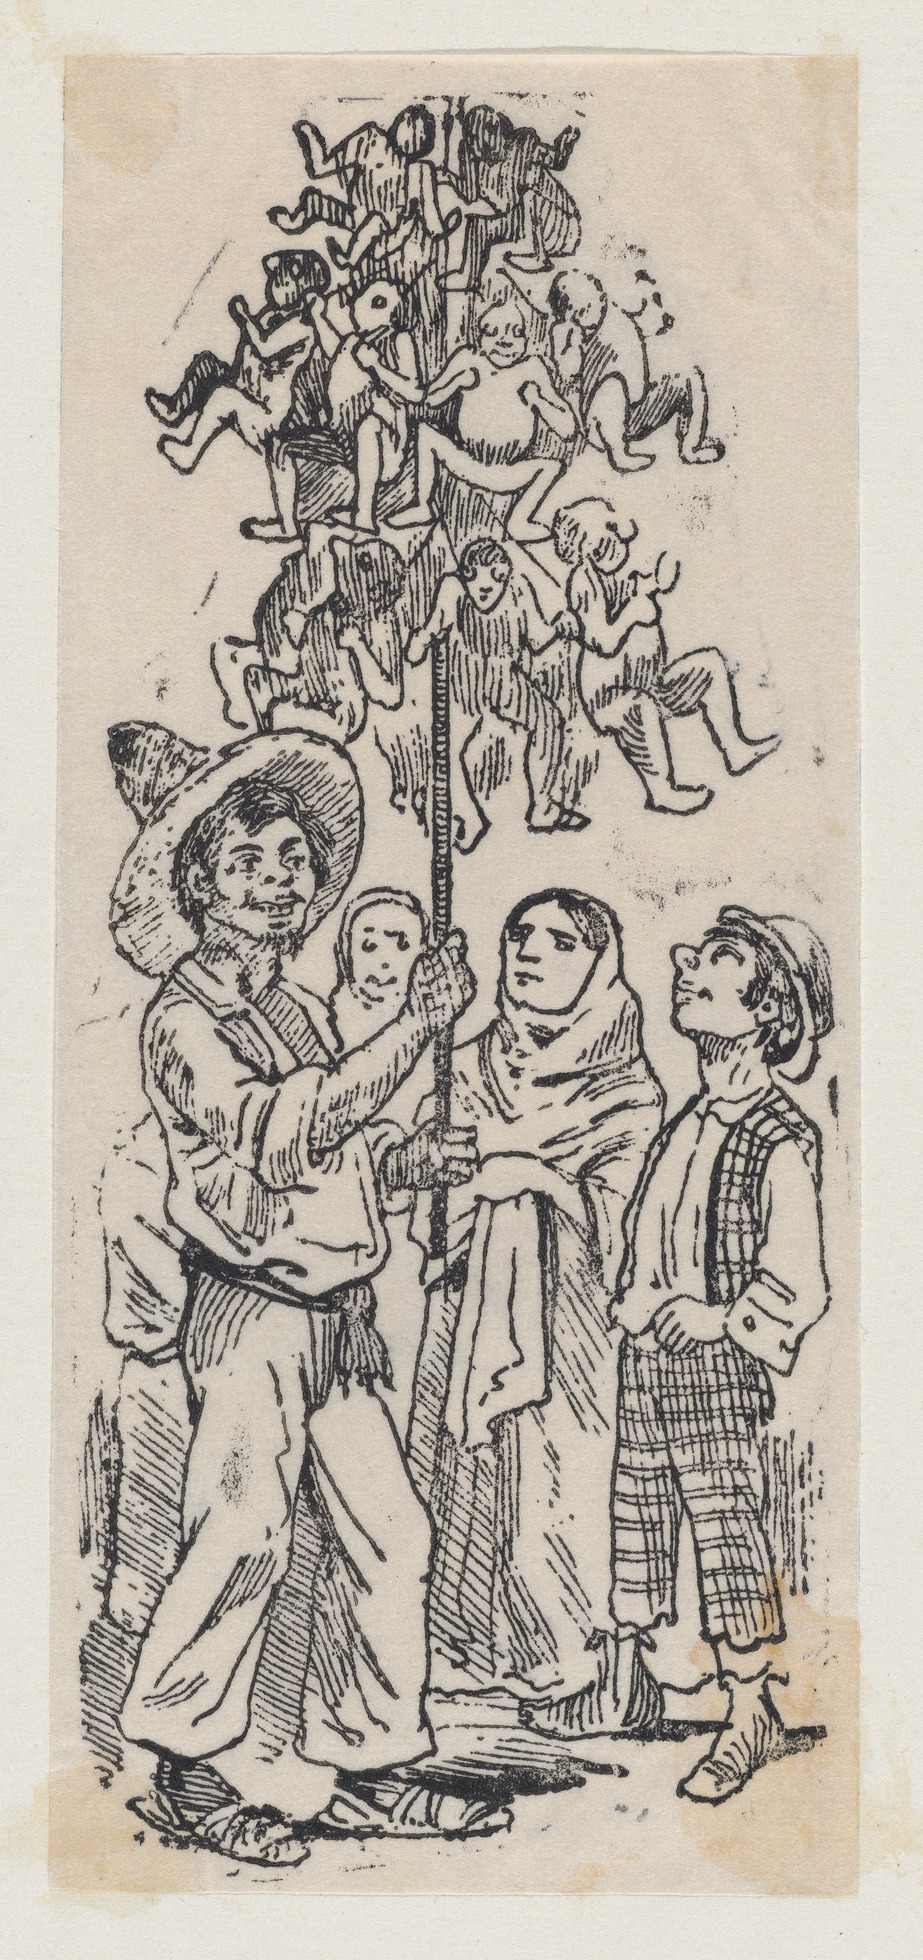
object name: print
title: A vendor selling toys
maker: josé guadalupe posada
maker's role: artist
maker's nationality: mexican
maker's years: 1852-1913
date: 1880-1910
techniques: lithography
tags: men,women,toys